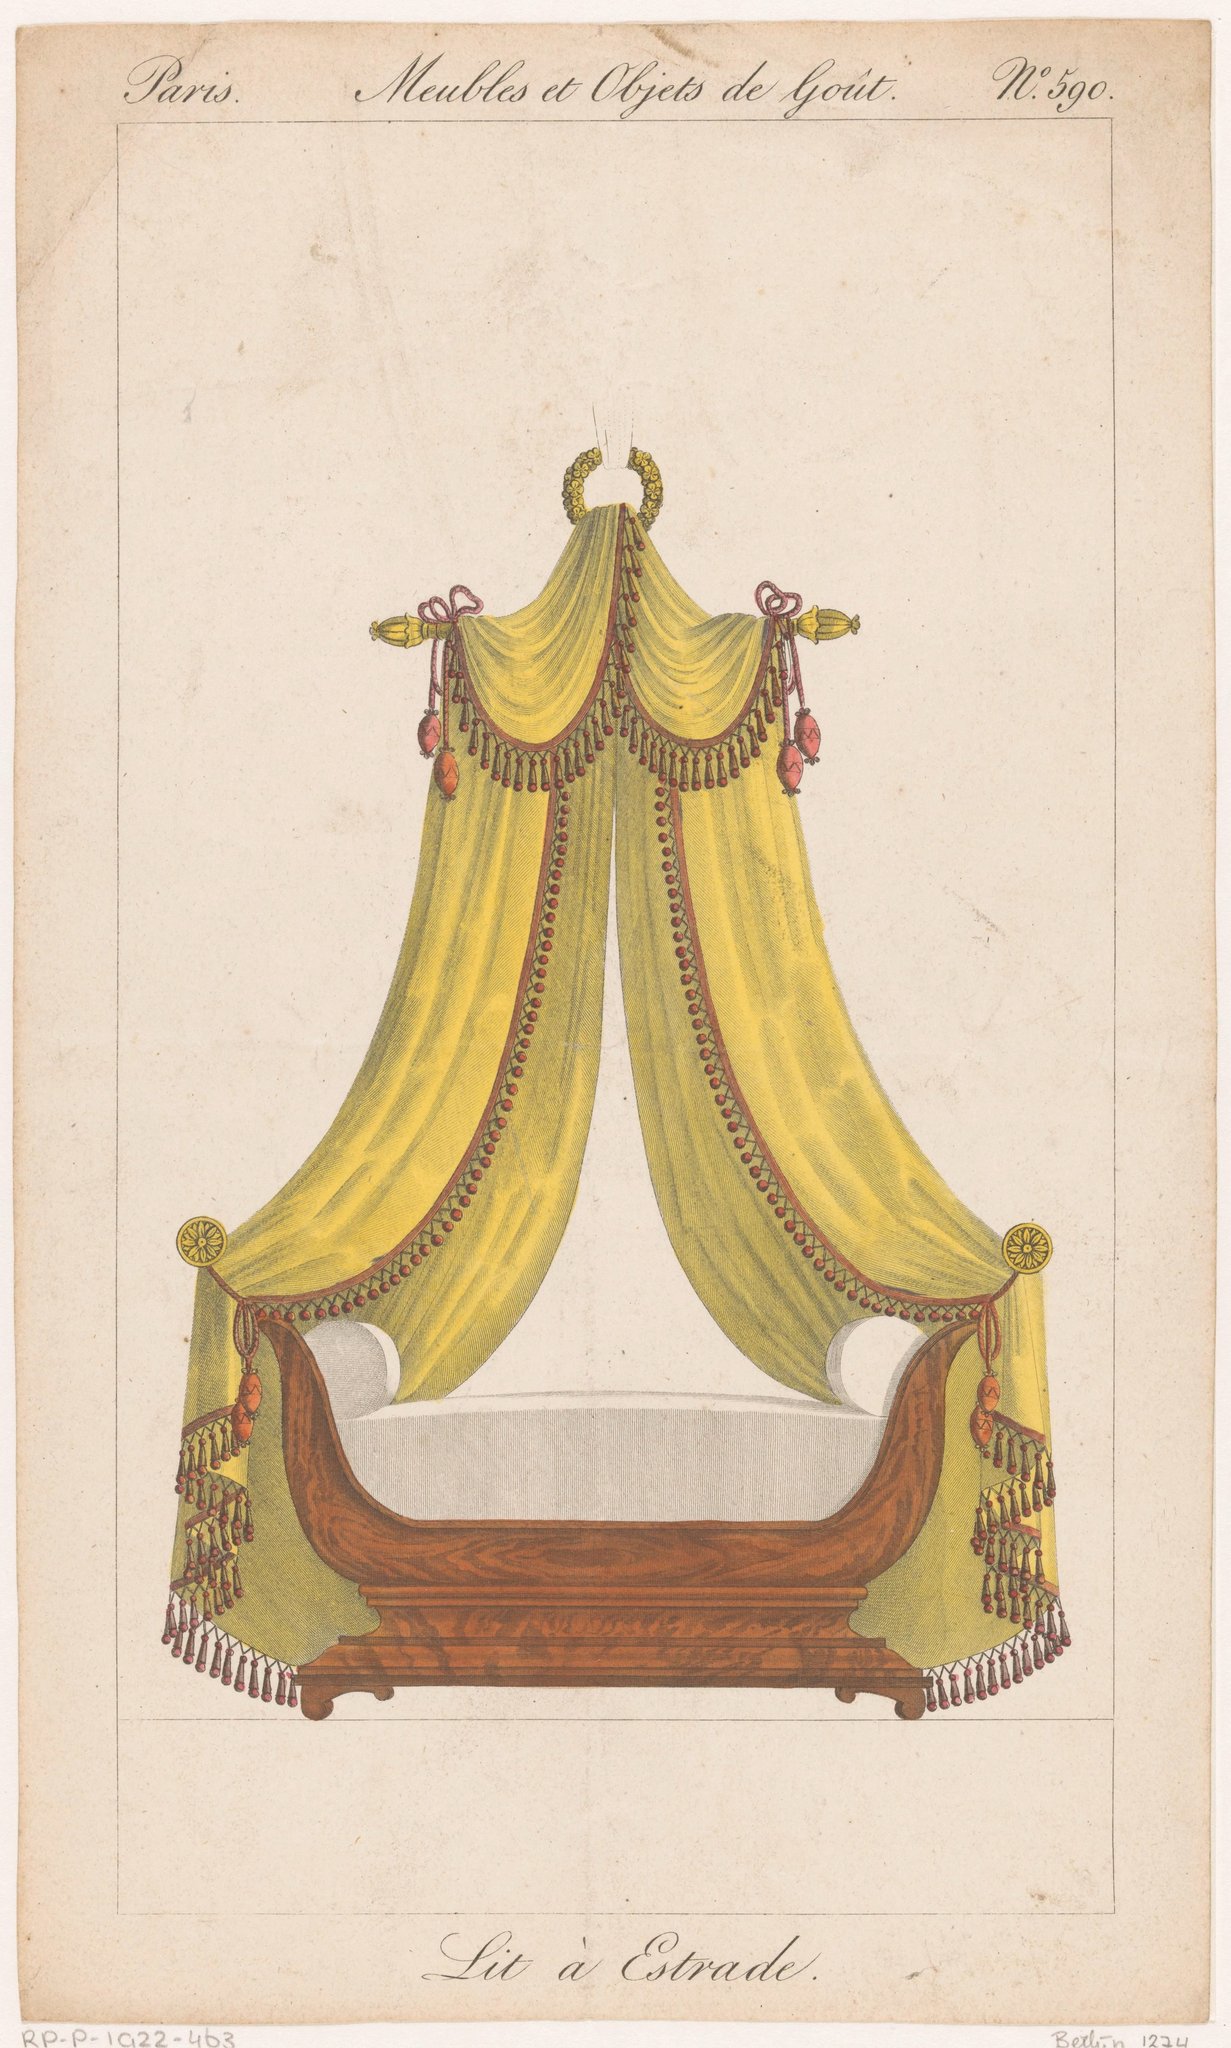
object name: print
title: Hemelbed met krans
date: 1801-1831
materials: paper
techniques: engraving, hand coloring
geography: paris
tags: bed with tester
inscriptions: collector's mark: Lugt 2233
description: Een ontwerp voor een hemelbed. De bekroning is gedecoreerd met een krans. Prentnummer 590.